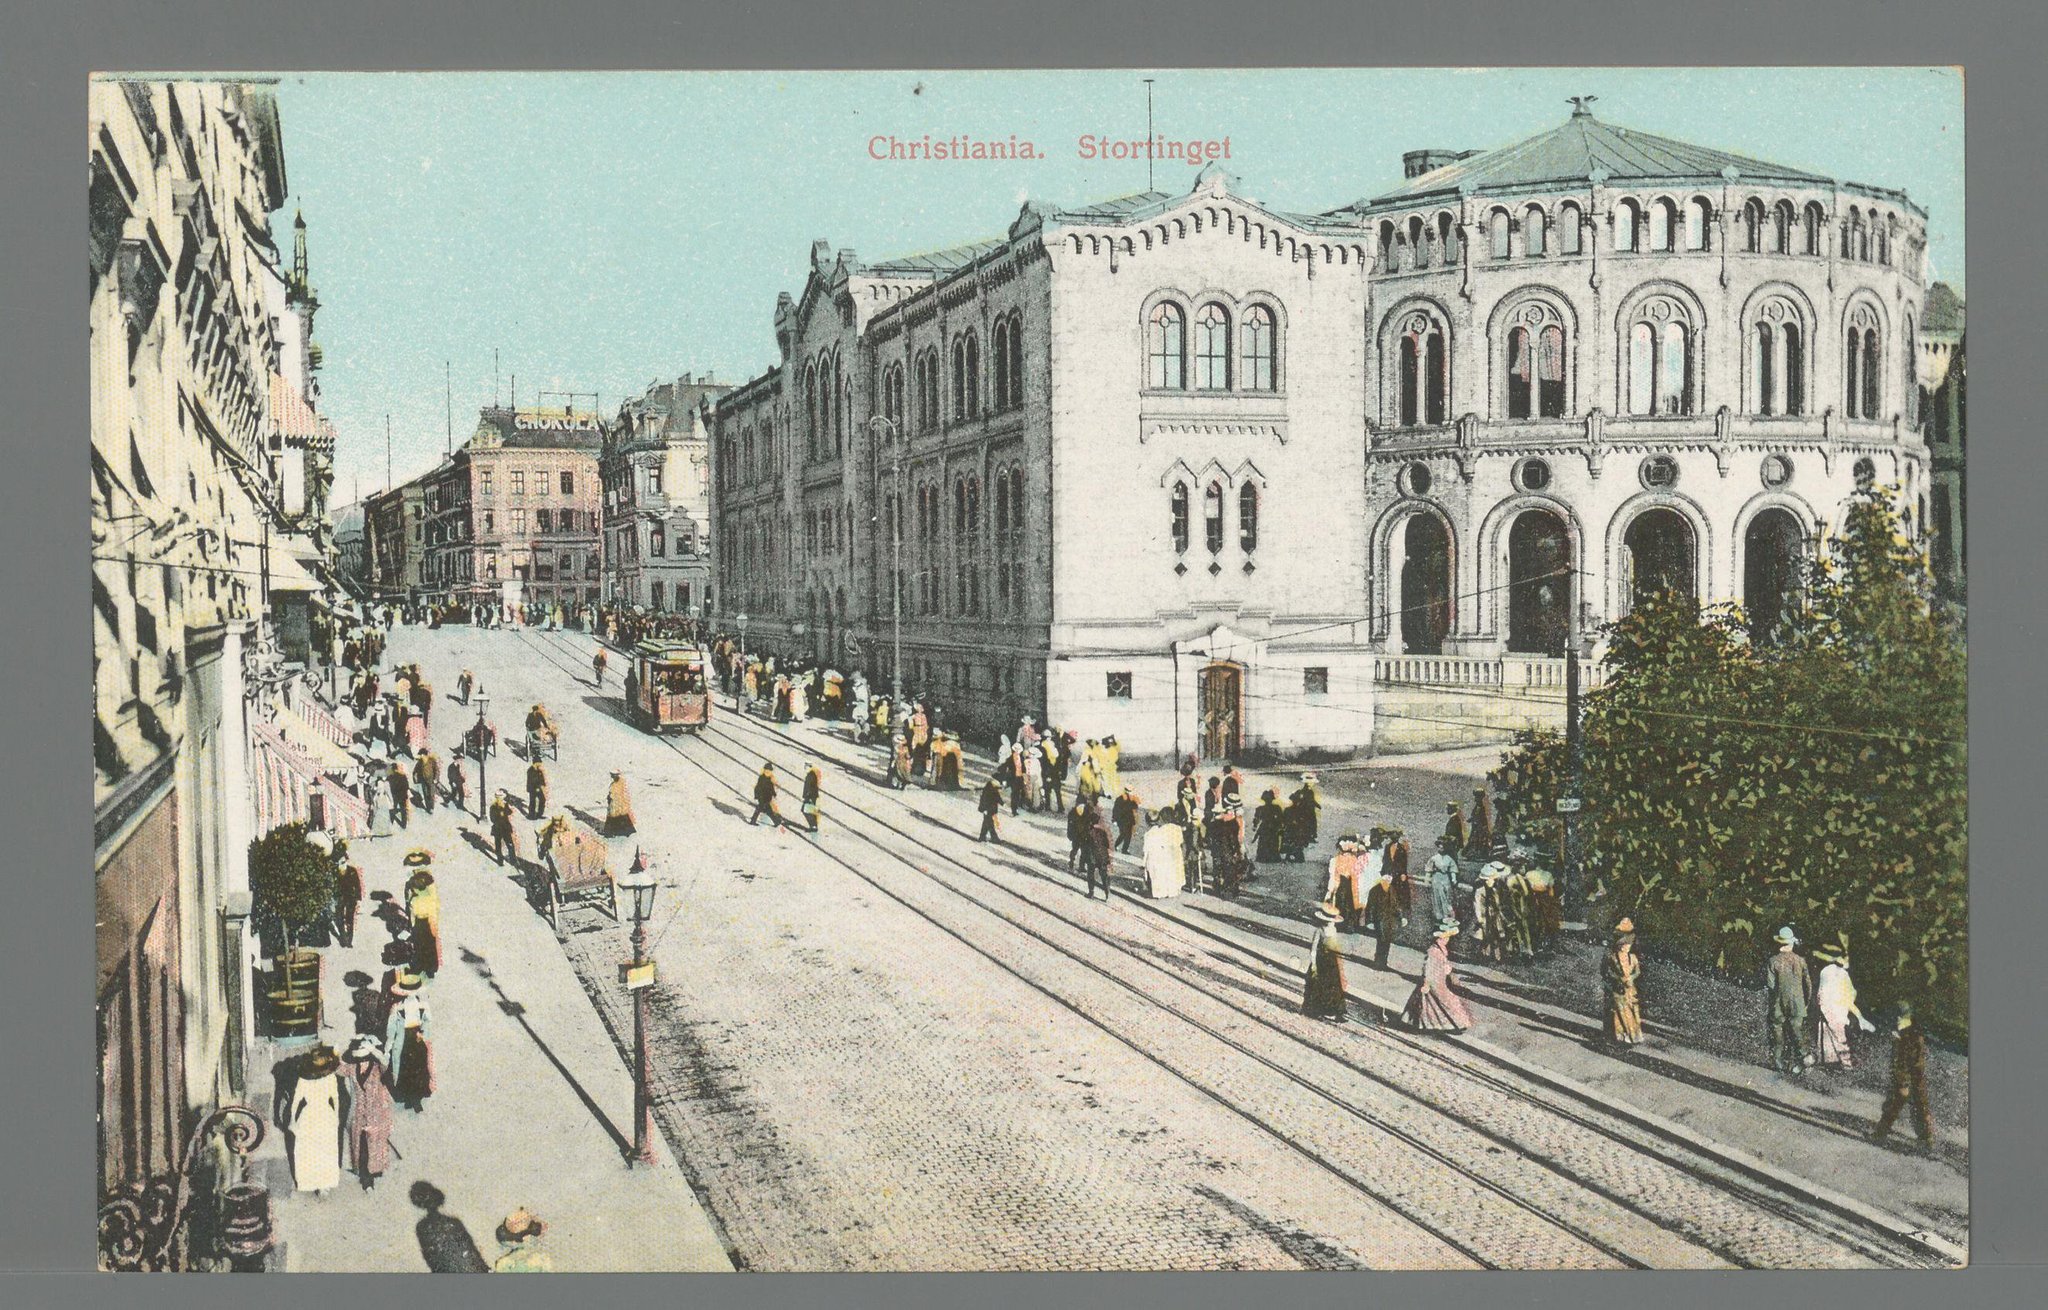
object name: photomechanical print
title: Christiania. Stortinget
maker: Anonymous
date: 1904-1930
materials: cardboard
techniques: photograph, lithograph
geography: oslo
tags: street, edifice, e.g.: public building, department store